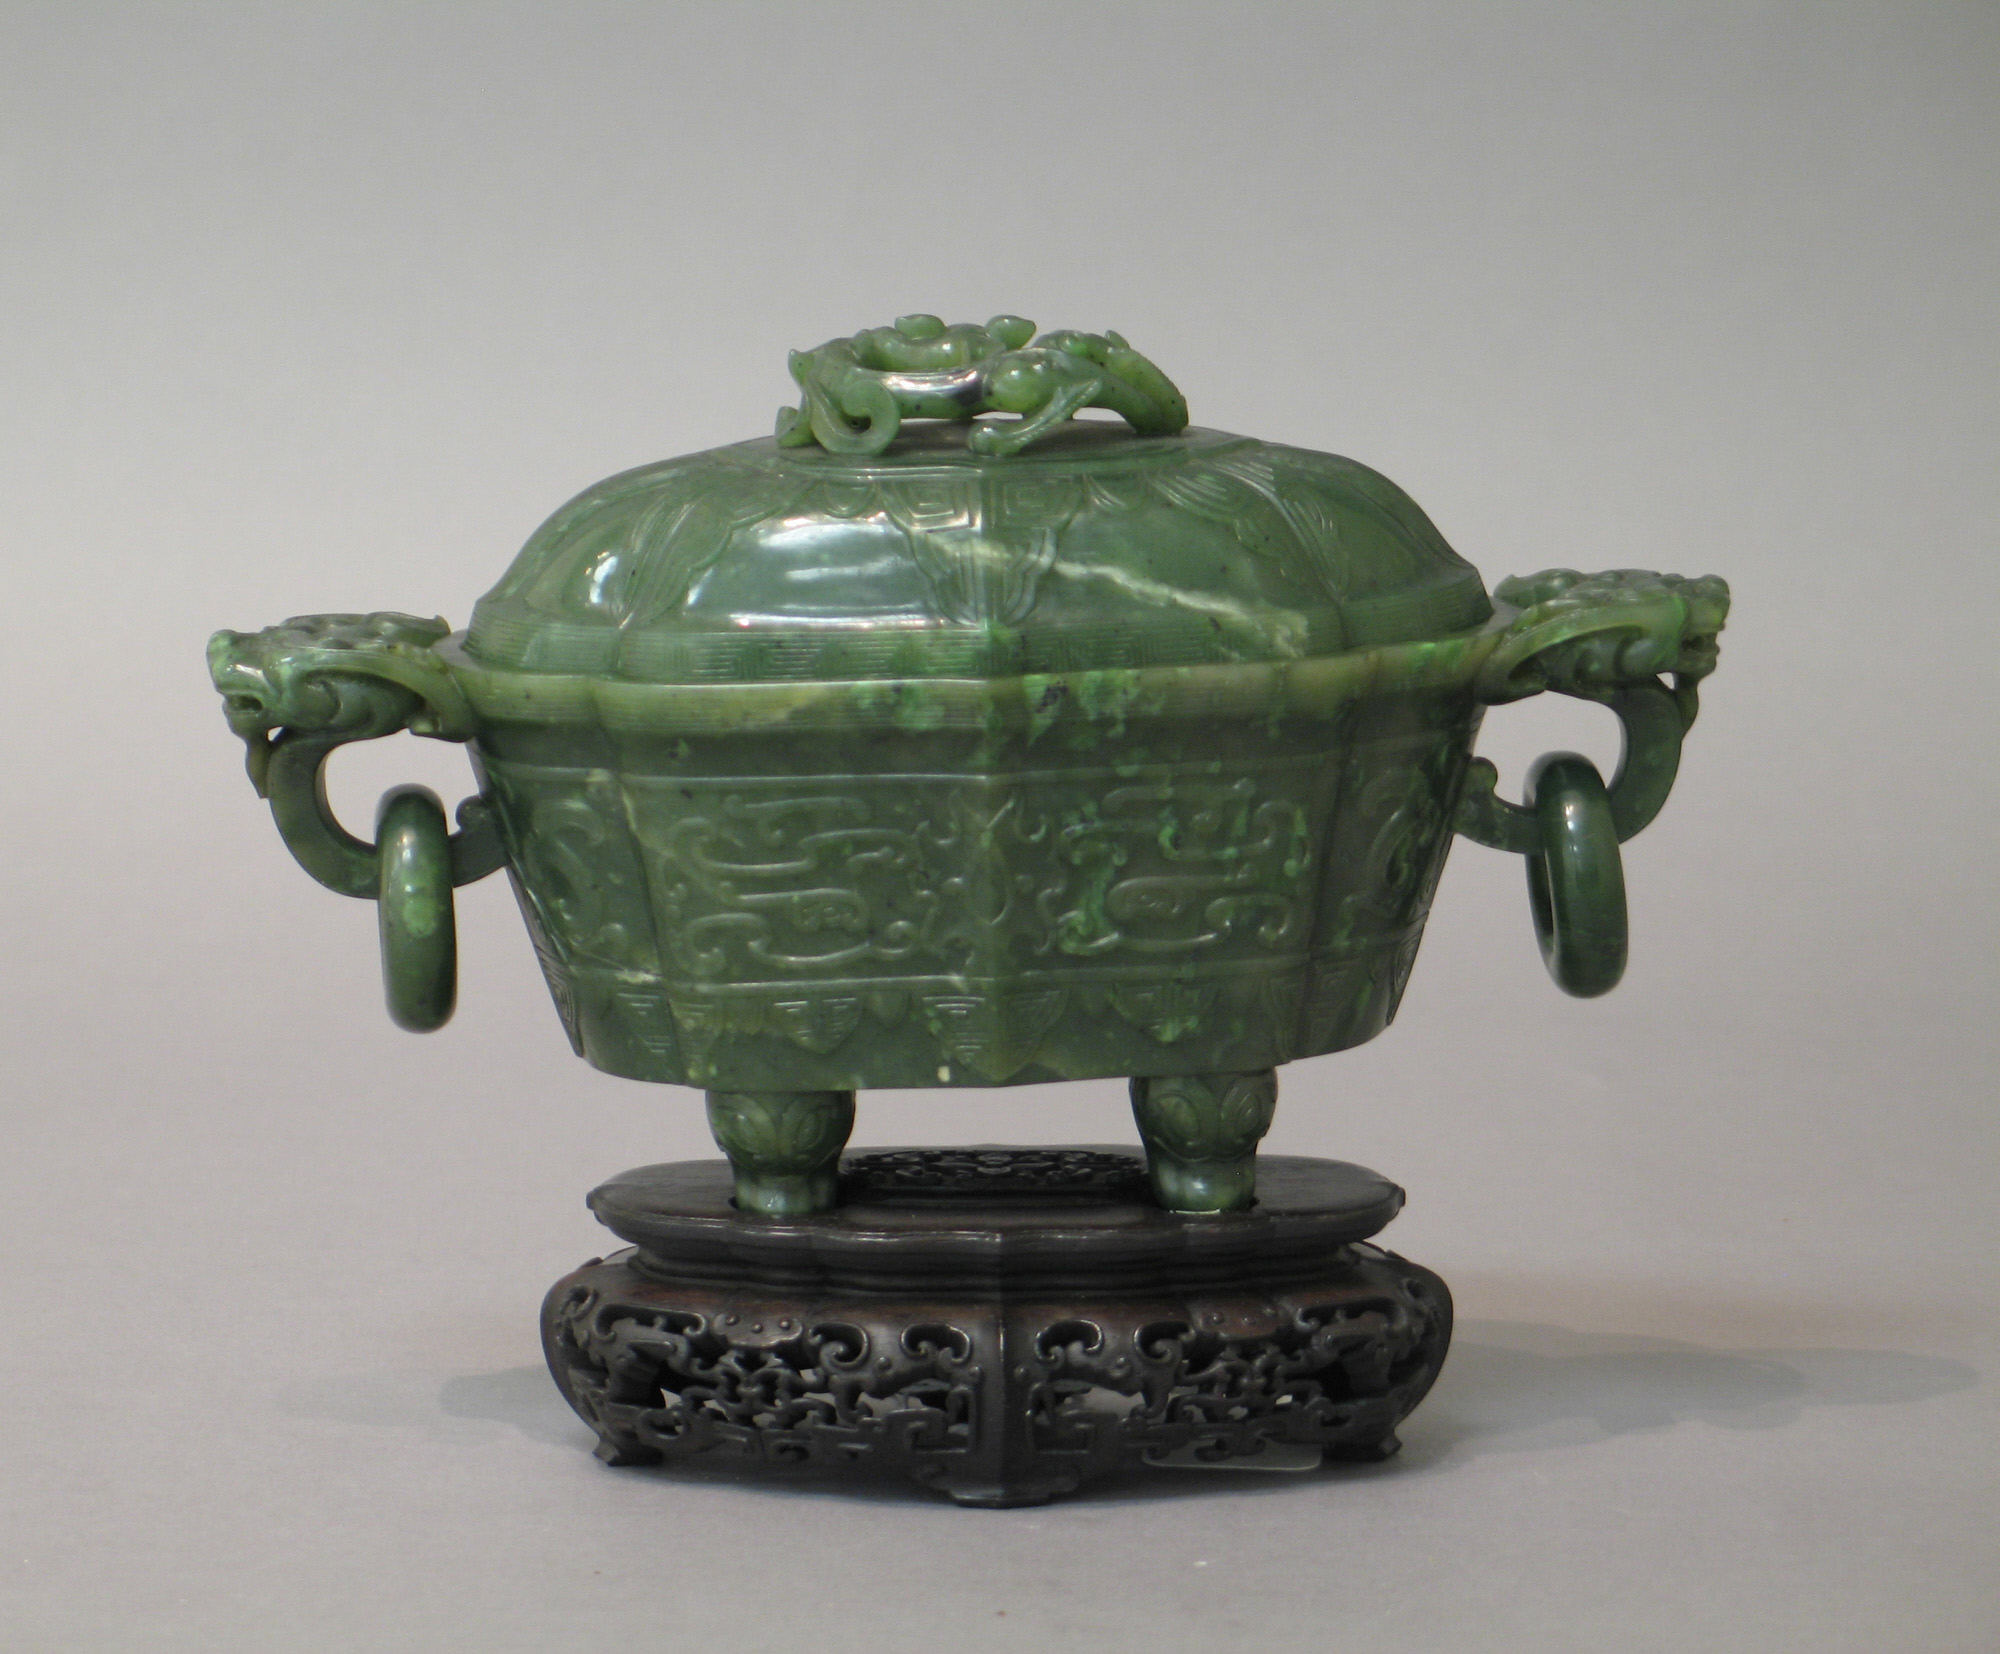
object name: urn with cover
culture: chinese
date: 1736-1795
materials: jade